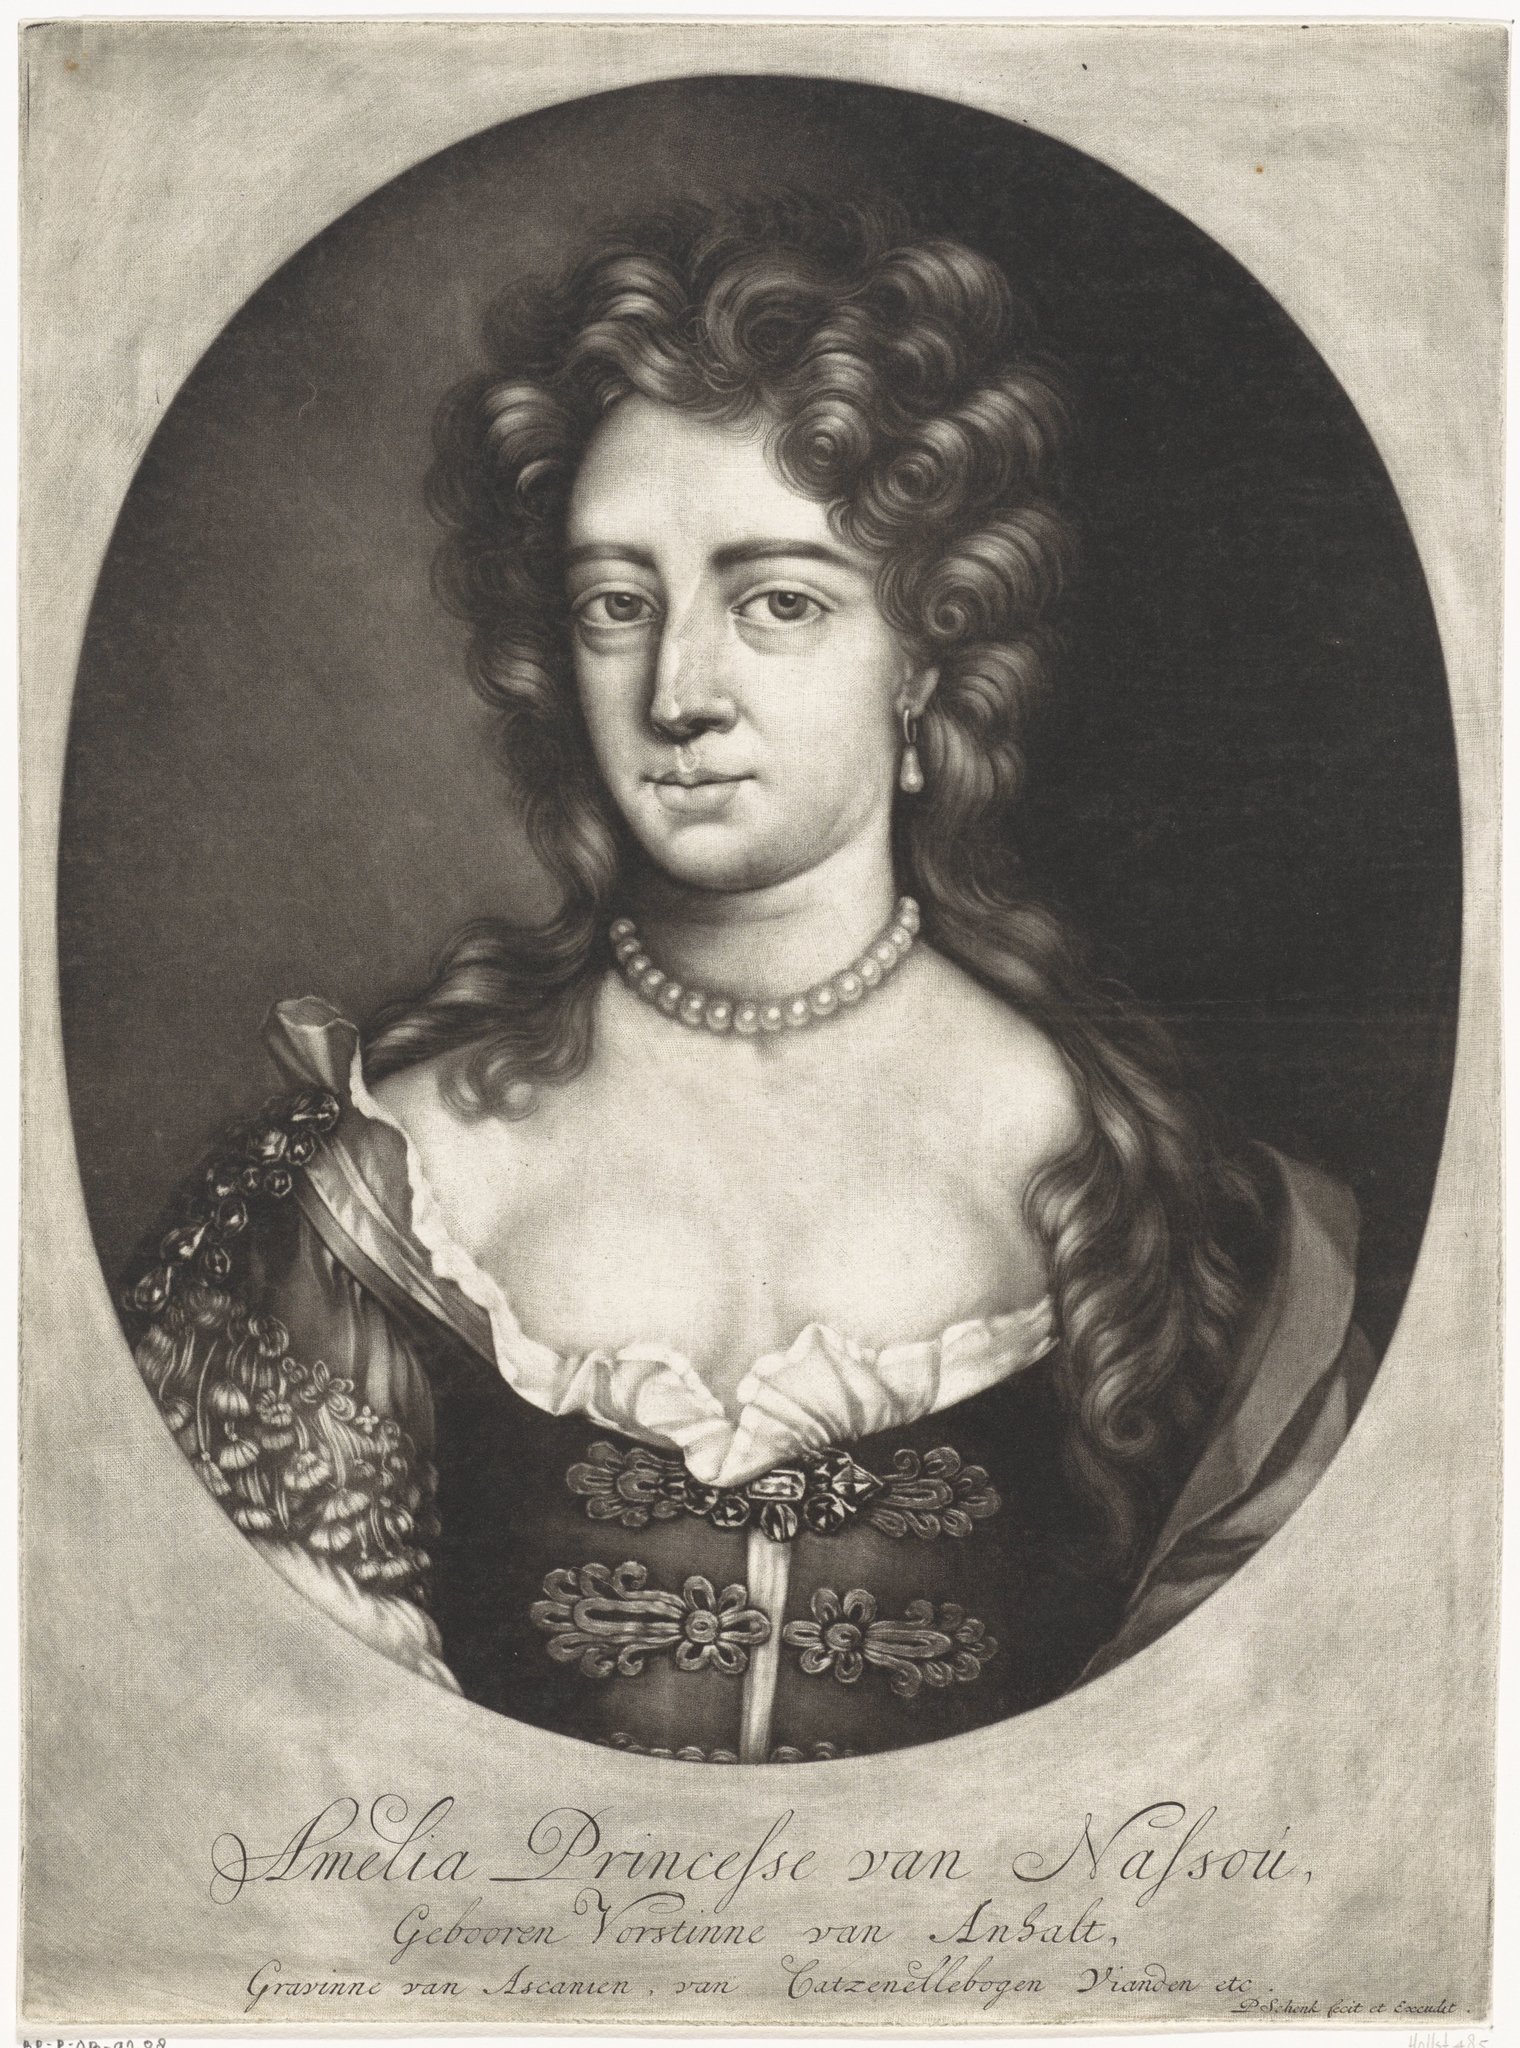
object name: print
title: Portret van Henriëtta Amalia, prinses van Anhalt-Dessau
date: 1670-1713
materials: paper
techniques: engraving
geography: amsterdam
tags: cleves, pearl; pearl necklace (+ women's clothes)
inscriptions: collector's mark: Lugt 240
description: Henriëtta Amalia, prinses van Anhalt-Dessau, echtgenote van Hendrick Casimir II. Ze draagt een parelsnoer.